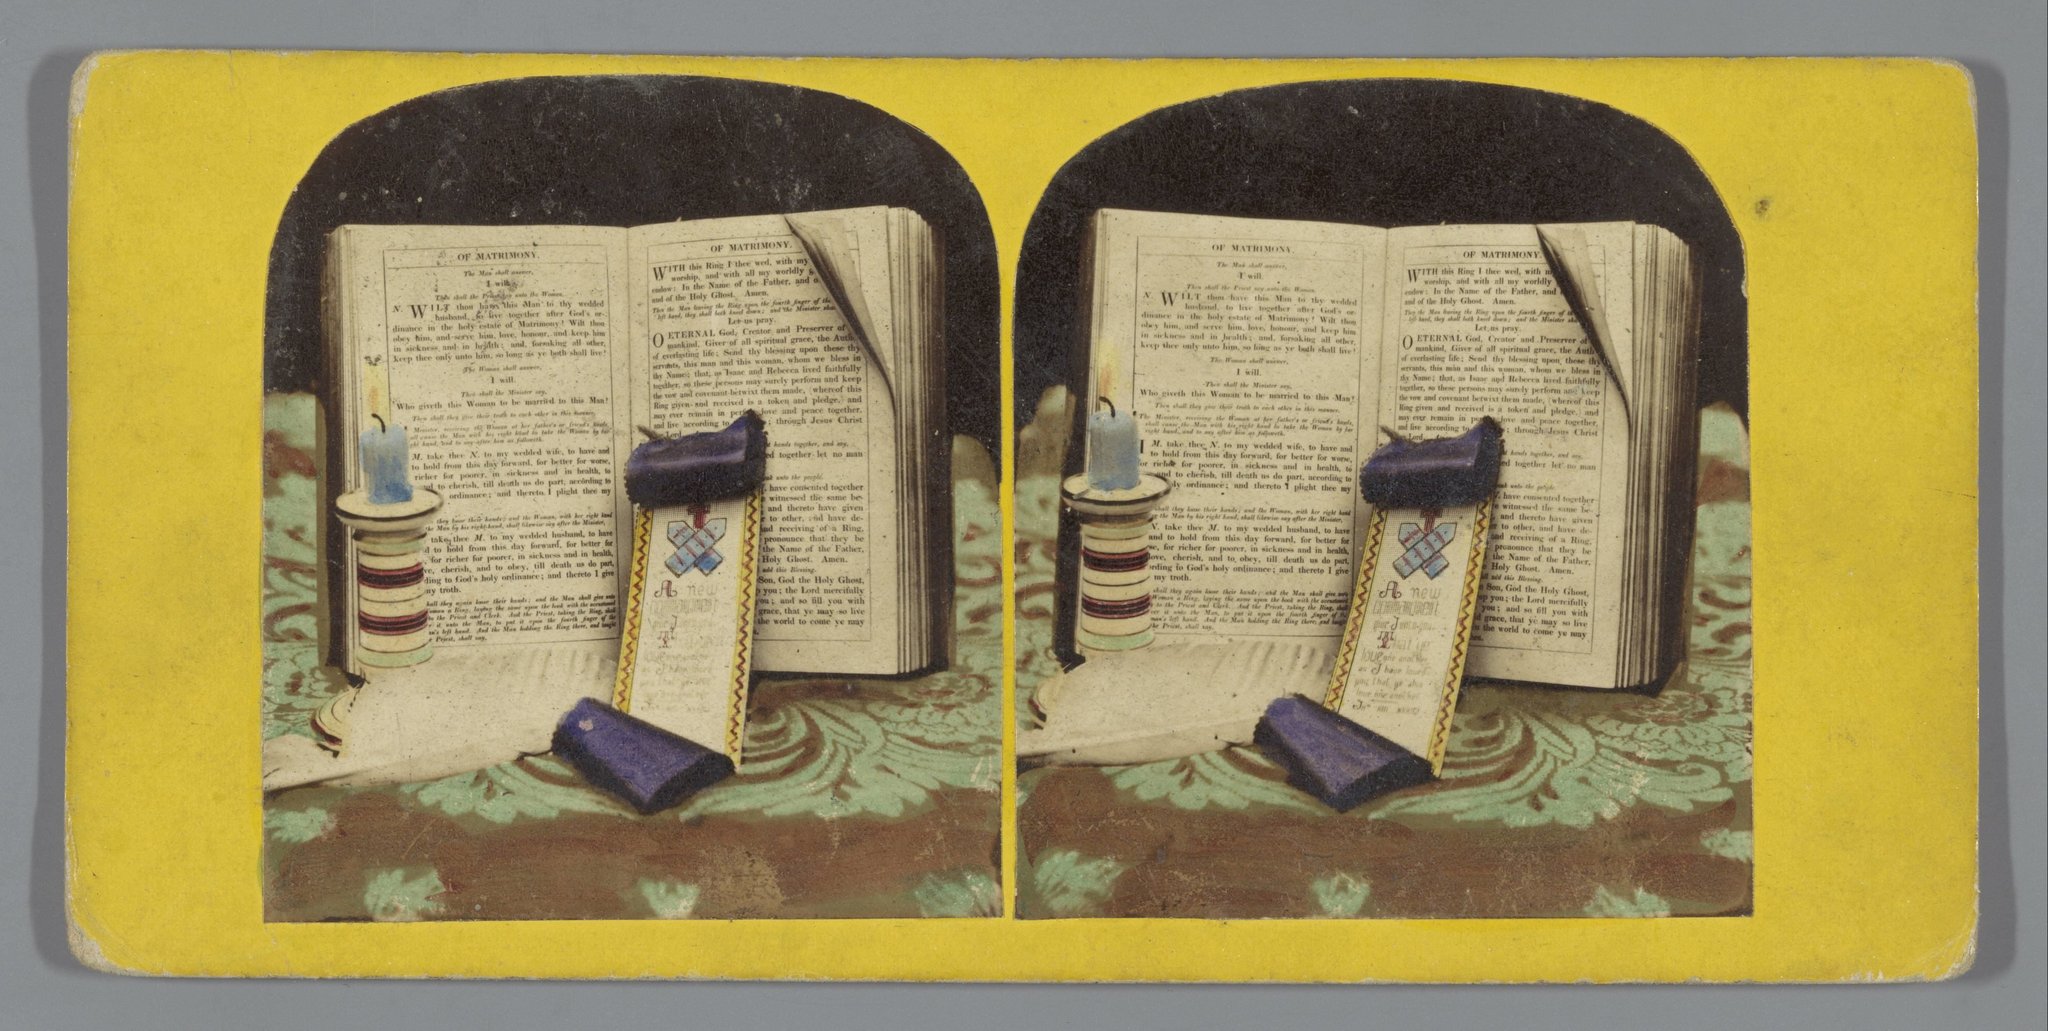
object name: stereograph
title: Stilleven met Book of Matrimony, kaars, veerpen en boekenlegger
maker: Anonymous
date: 1855-1870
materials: cardboard, photographic support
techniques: albumen print, hand coloring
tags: bible, candle, still life of miscellaneous objects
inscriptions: stamp: ‘[...]’, number: ‘16’, number: ‘13’, number: ‘7’